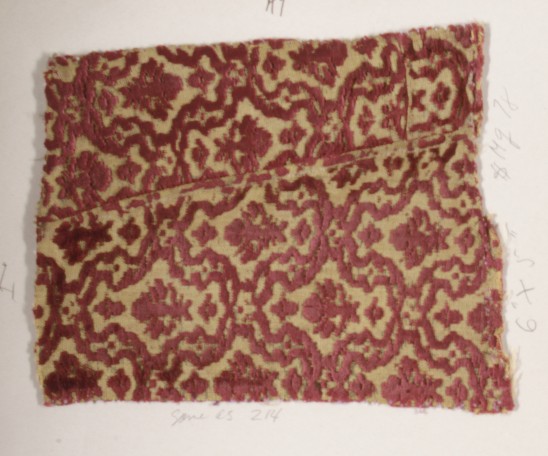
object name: fragment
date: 1701-1800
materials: metal thread, silk